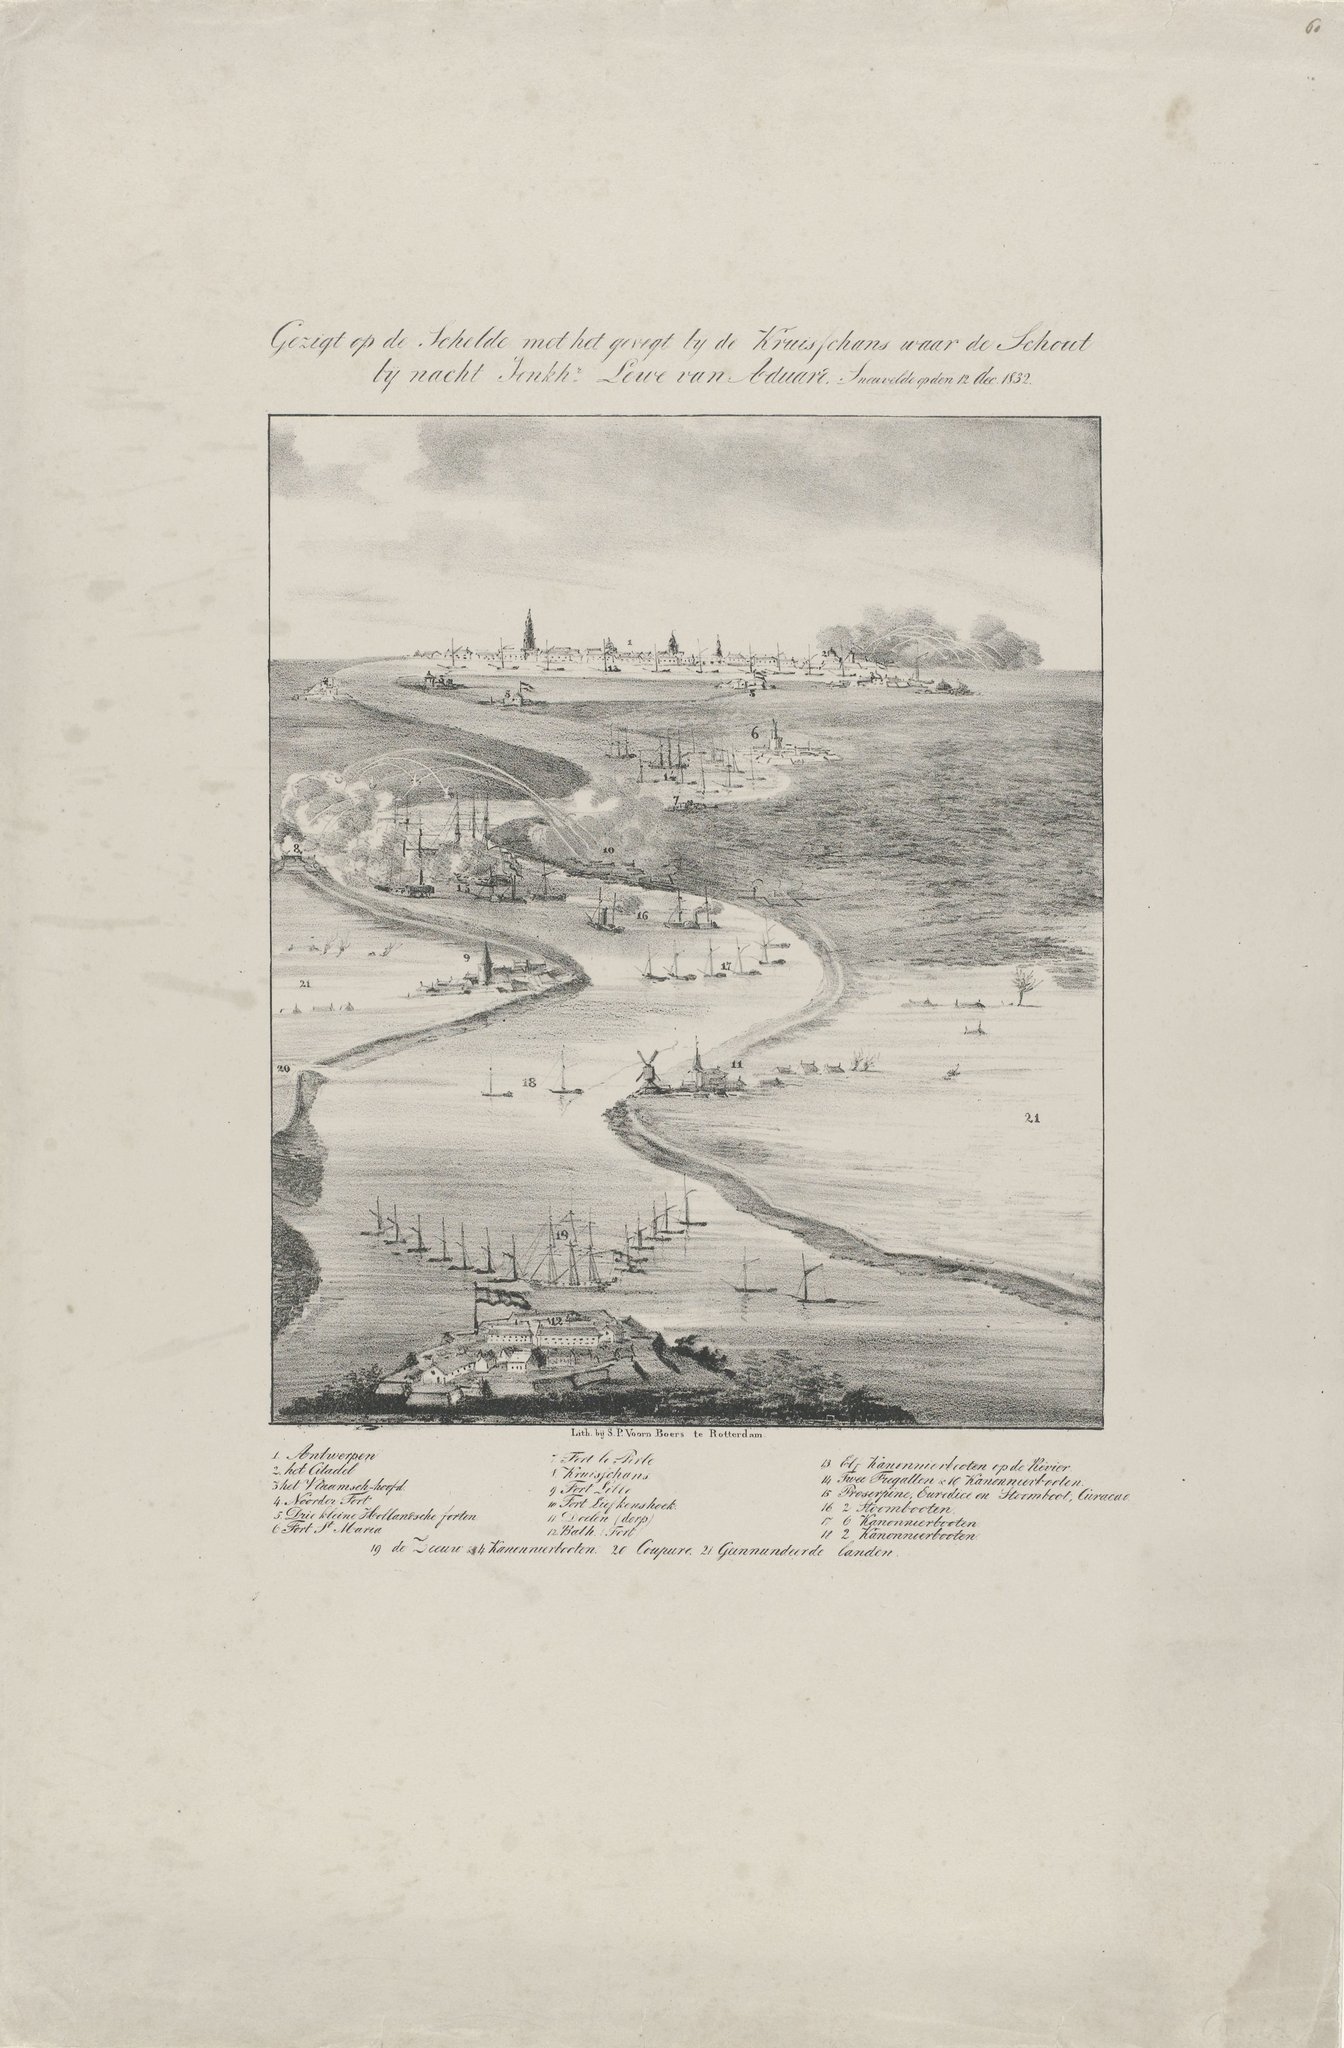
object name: print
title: Gezigt op de Schelde met het gevegt bij de Kruisschans waar de Schout bij nacht Jonkhr. Lewe van Aduard sneuvelde op den 12 dec. 1832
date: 1832-1833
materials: paper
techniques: lithograph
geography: netherlands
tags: bombardment ~ siege (+ naval force), siege, position war, bombardment ~ siege, antwerp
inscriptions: collector's mark: Lugt 2228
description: Gezicht op de loop van de Schelde van Fort Bath tot aan Antwerpen. Halverwege het gevecht bij de Kruisschans op 12 december 1832 waarbij Jan Evert Lewe van Aduard om het leven kwam. In de verte de beschieting van de Citadel van Antwerpen door de Fransen. Onderaan de legenda 1-21.